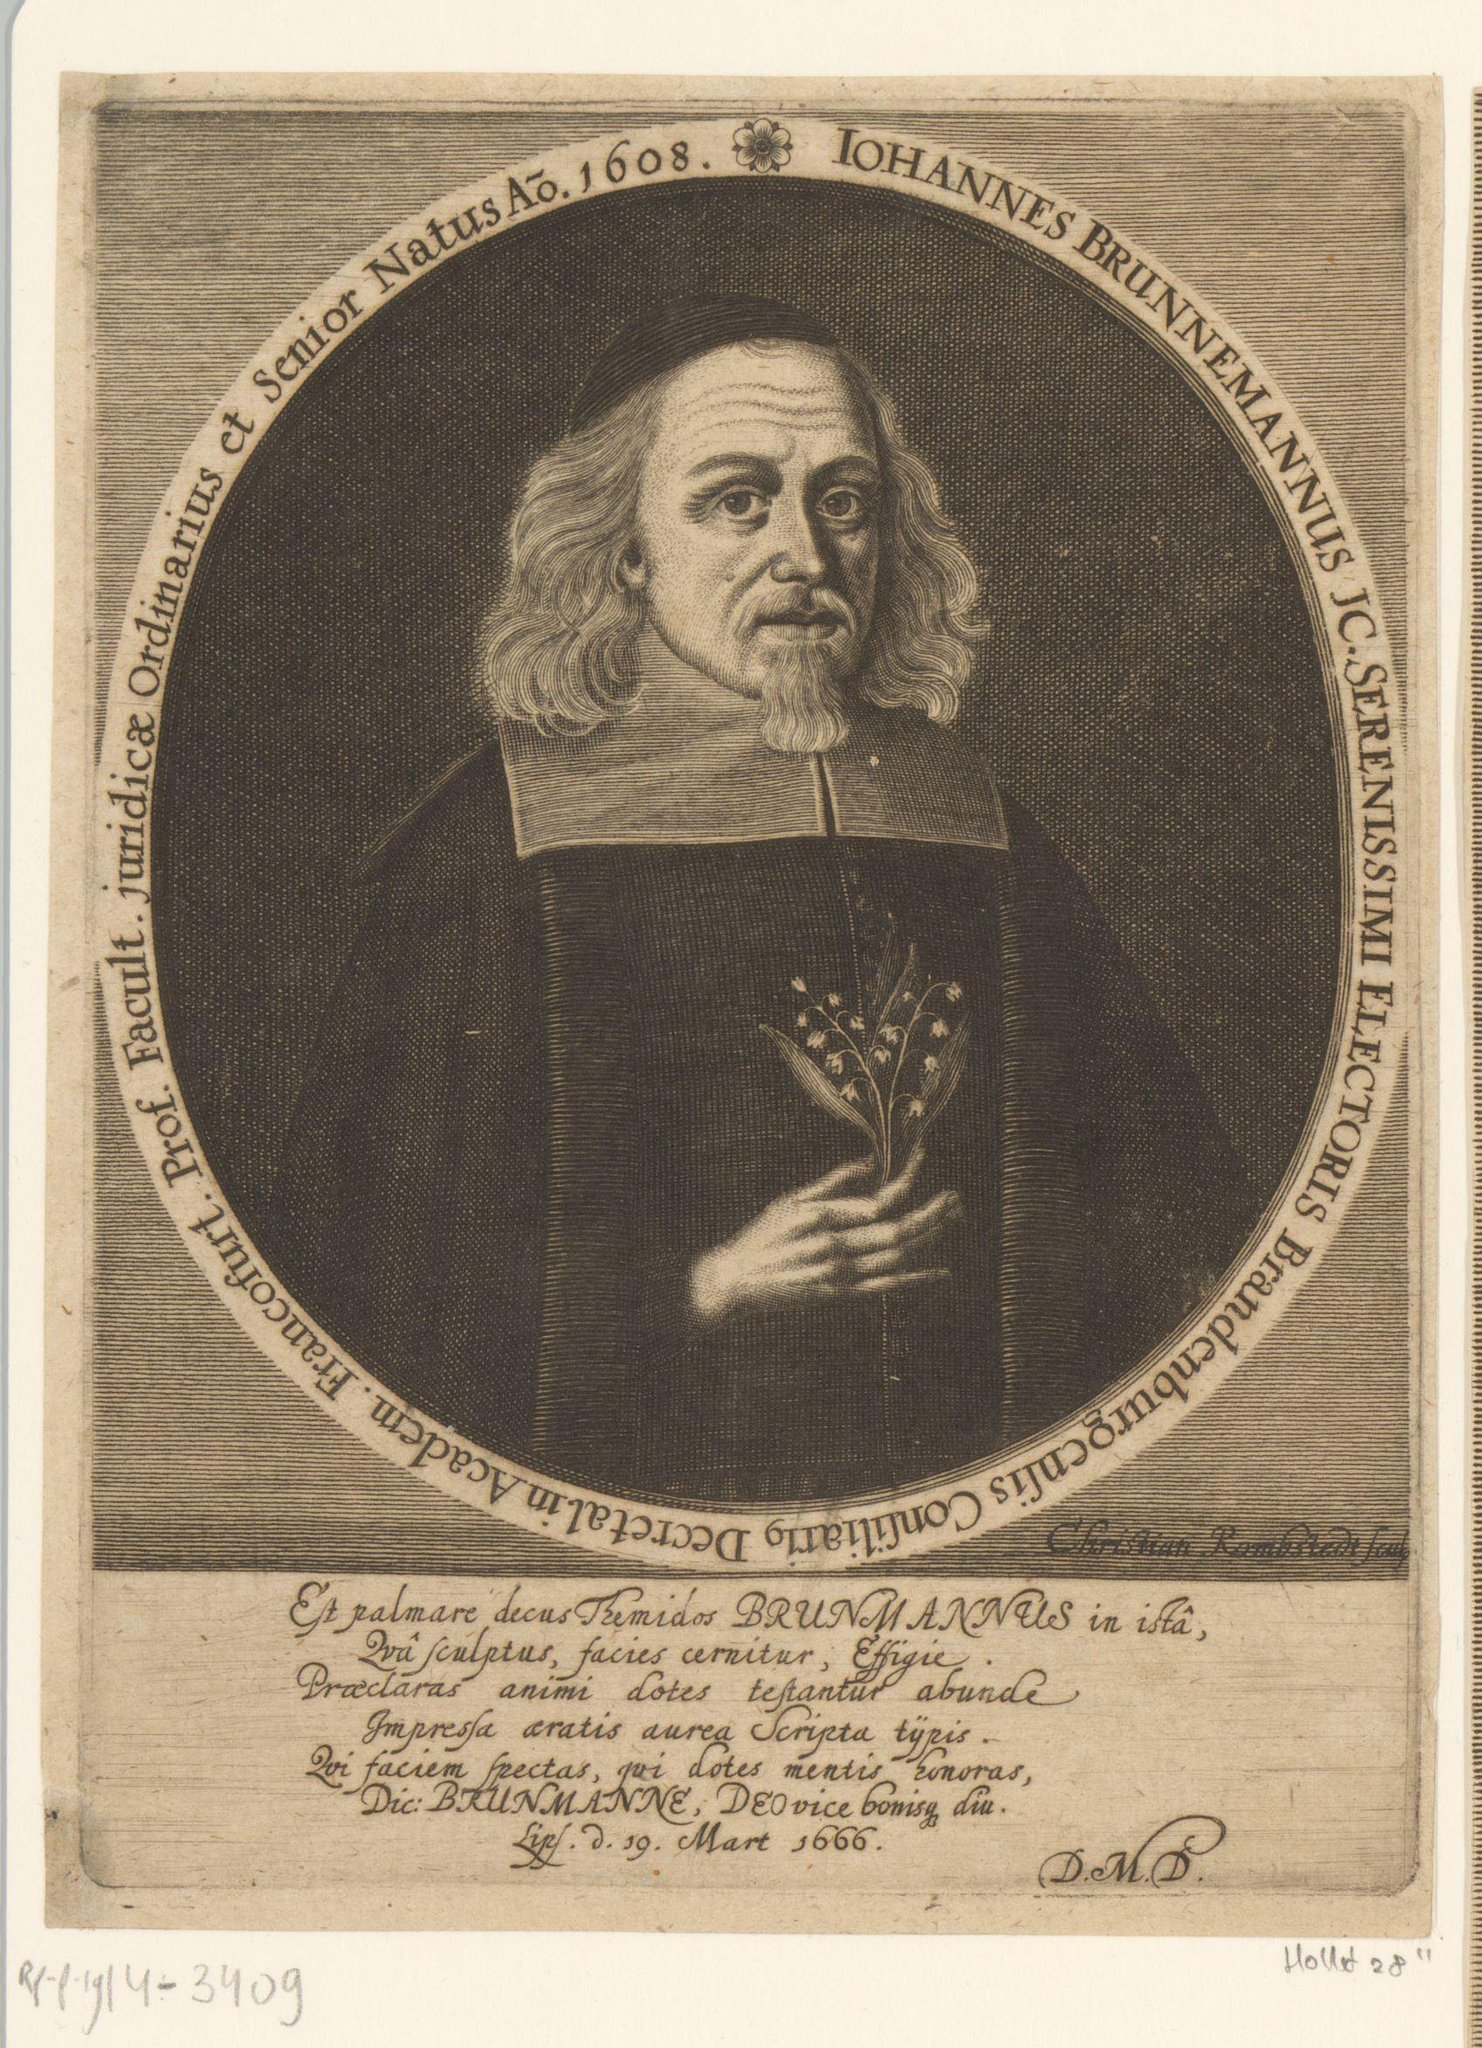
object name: print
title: Portret van Johann Brunnemann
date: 1665-1721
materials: paper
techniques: engraving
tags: flowers, historical persons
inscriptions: collector's mark: Lugt 2228